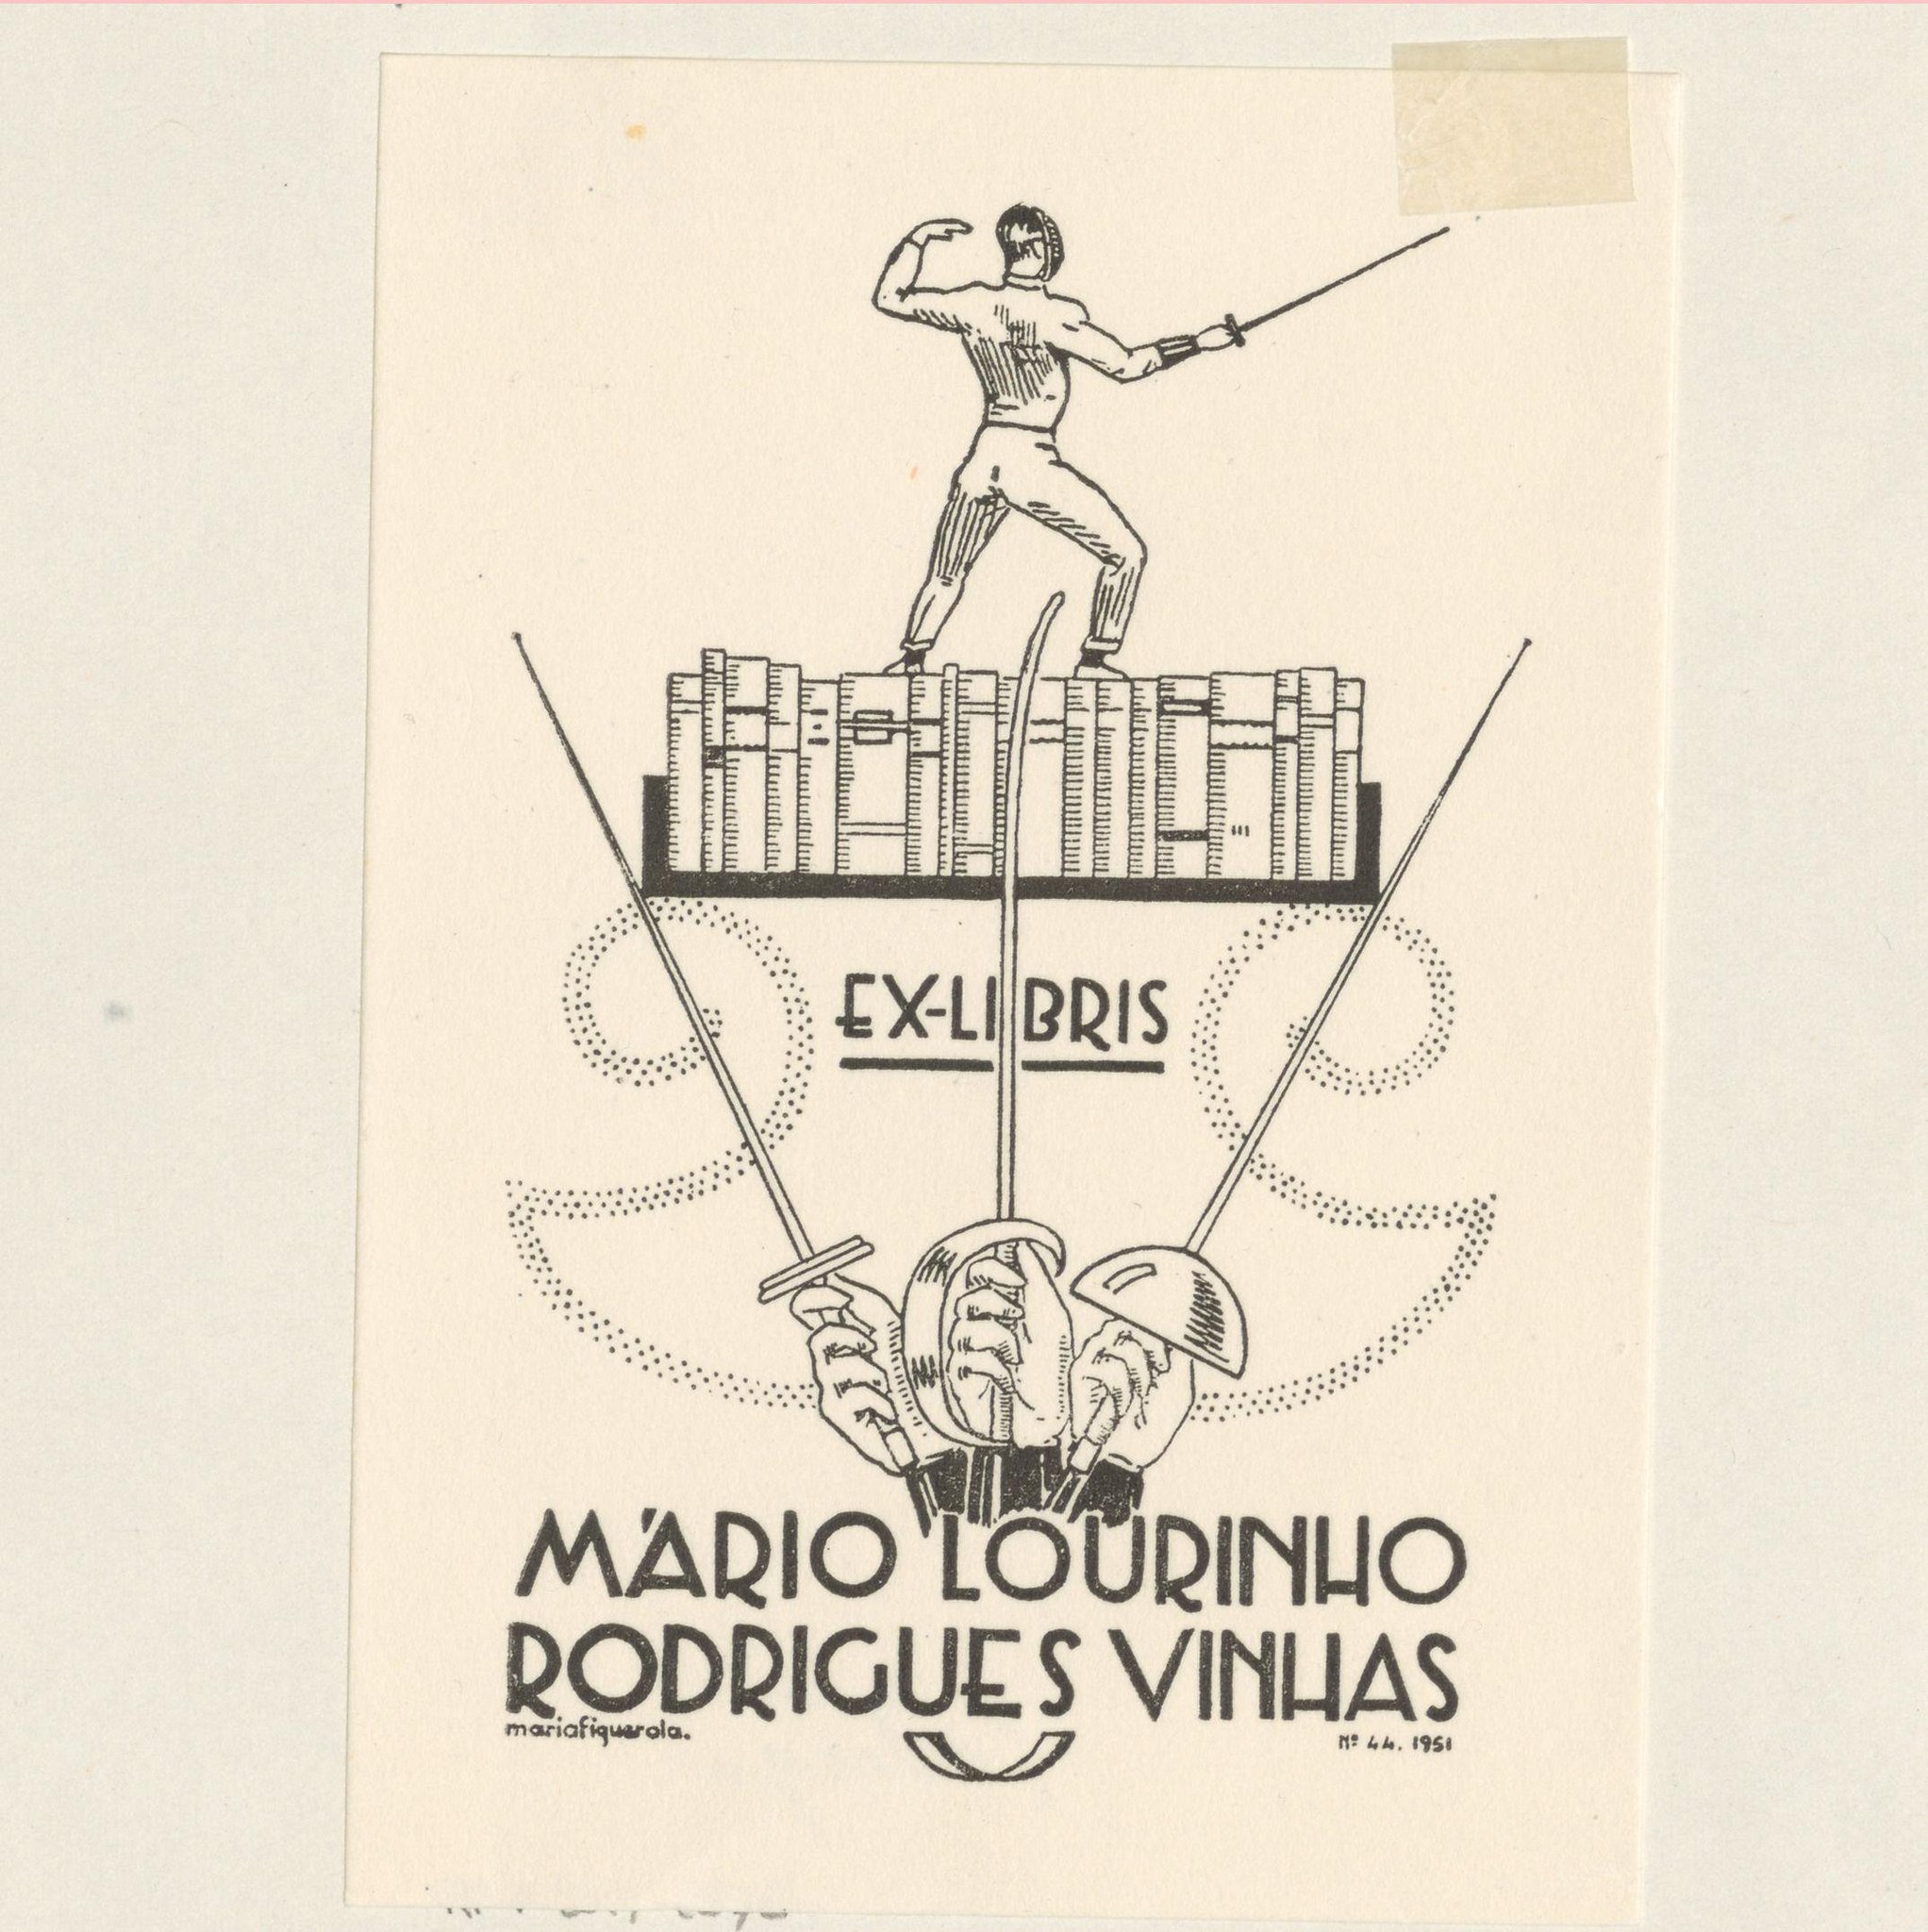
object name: bookplate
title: Ex libris van Mário Lourinho Rodrigues Vinhas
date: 1951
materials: paper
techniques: printing block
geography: spain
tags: sabre (~ fencing), bookshelves, book, fencing (sport)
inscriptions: date